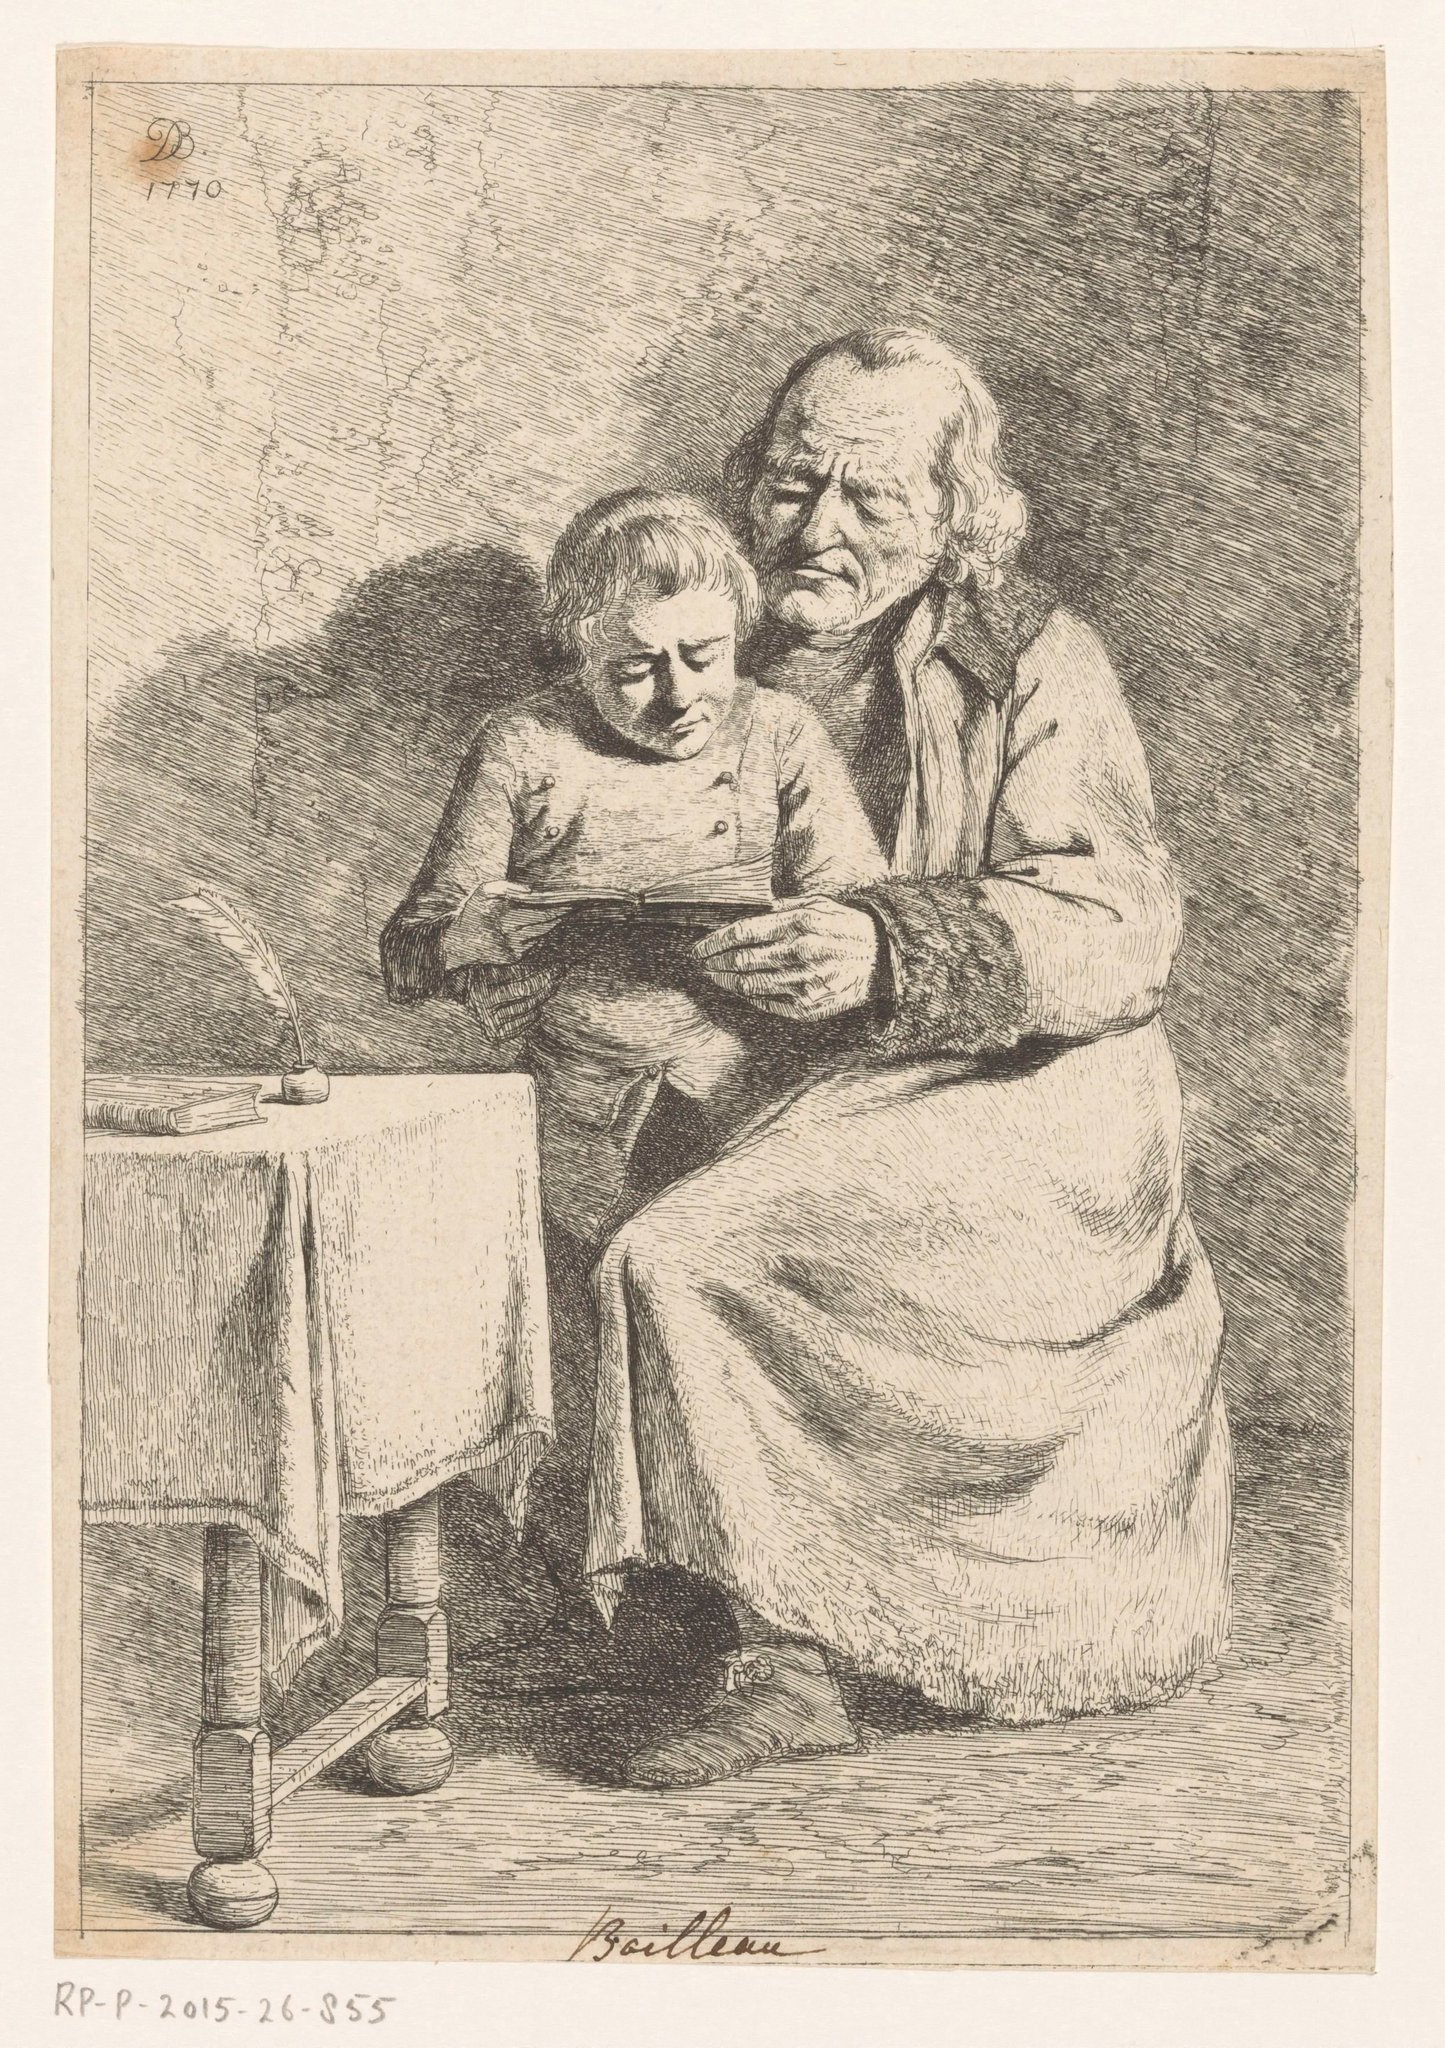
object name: print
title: Jongen leest een boek samen met een oude man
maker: jean jacques de boissieu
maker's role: draughtsman, print maker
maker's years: 1736-1810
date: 1770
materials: paper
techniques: etching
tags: boy (child between toddler and youth), old man, newspaper, news-sheet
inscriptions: collector's mark: Lugt 2228, collector's mark: Lugt 4780, annotation: ‘Boilleau’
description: Op de voorgrond een tafel met een boek en een inktpot met veer.